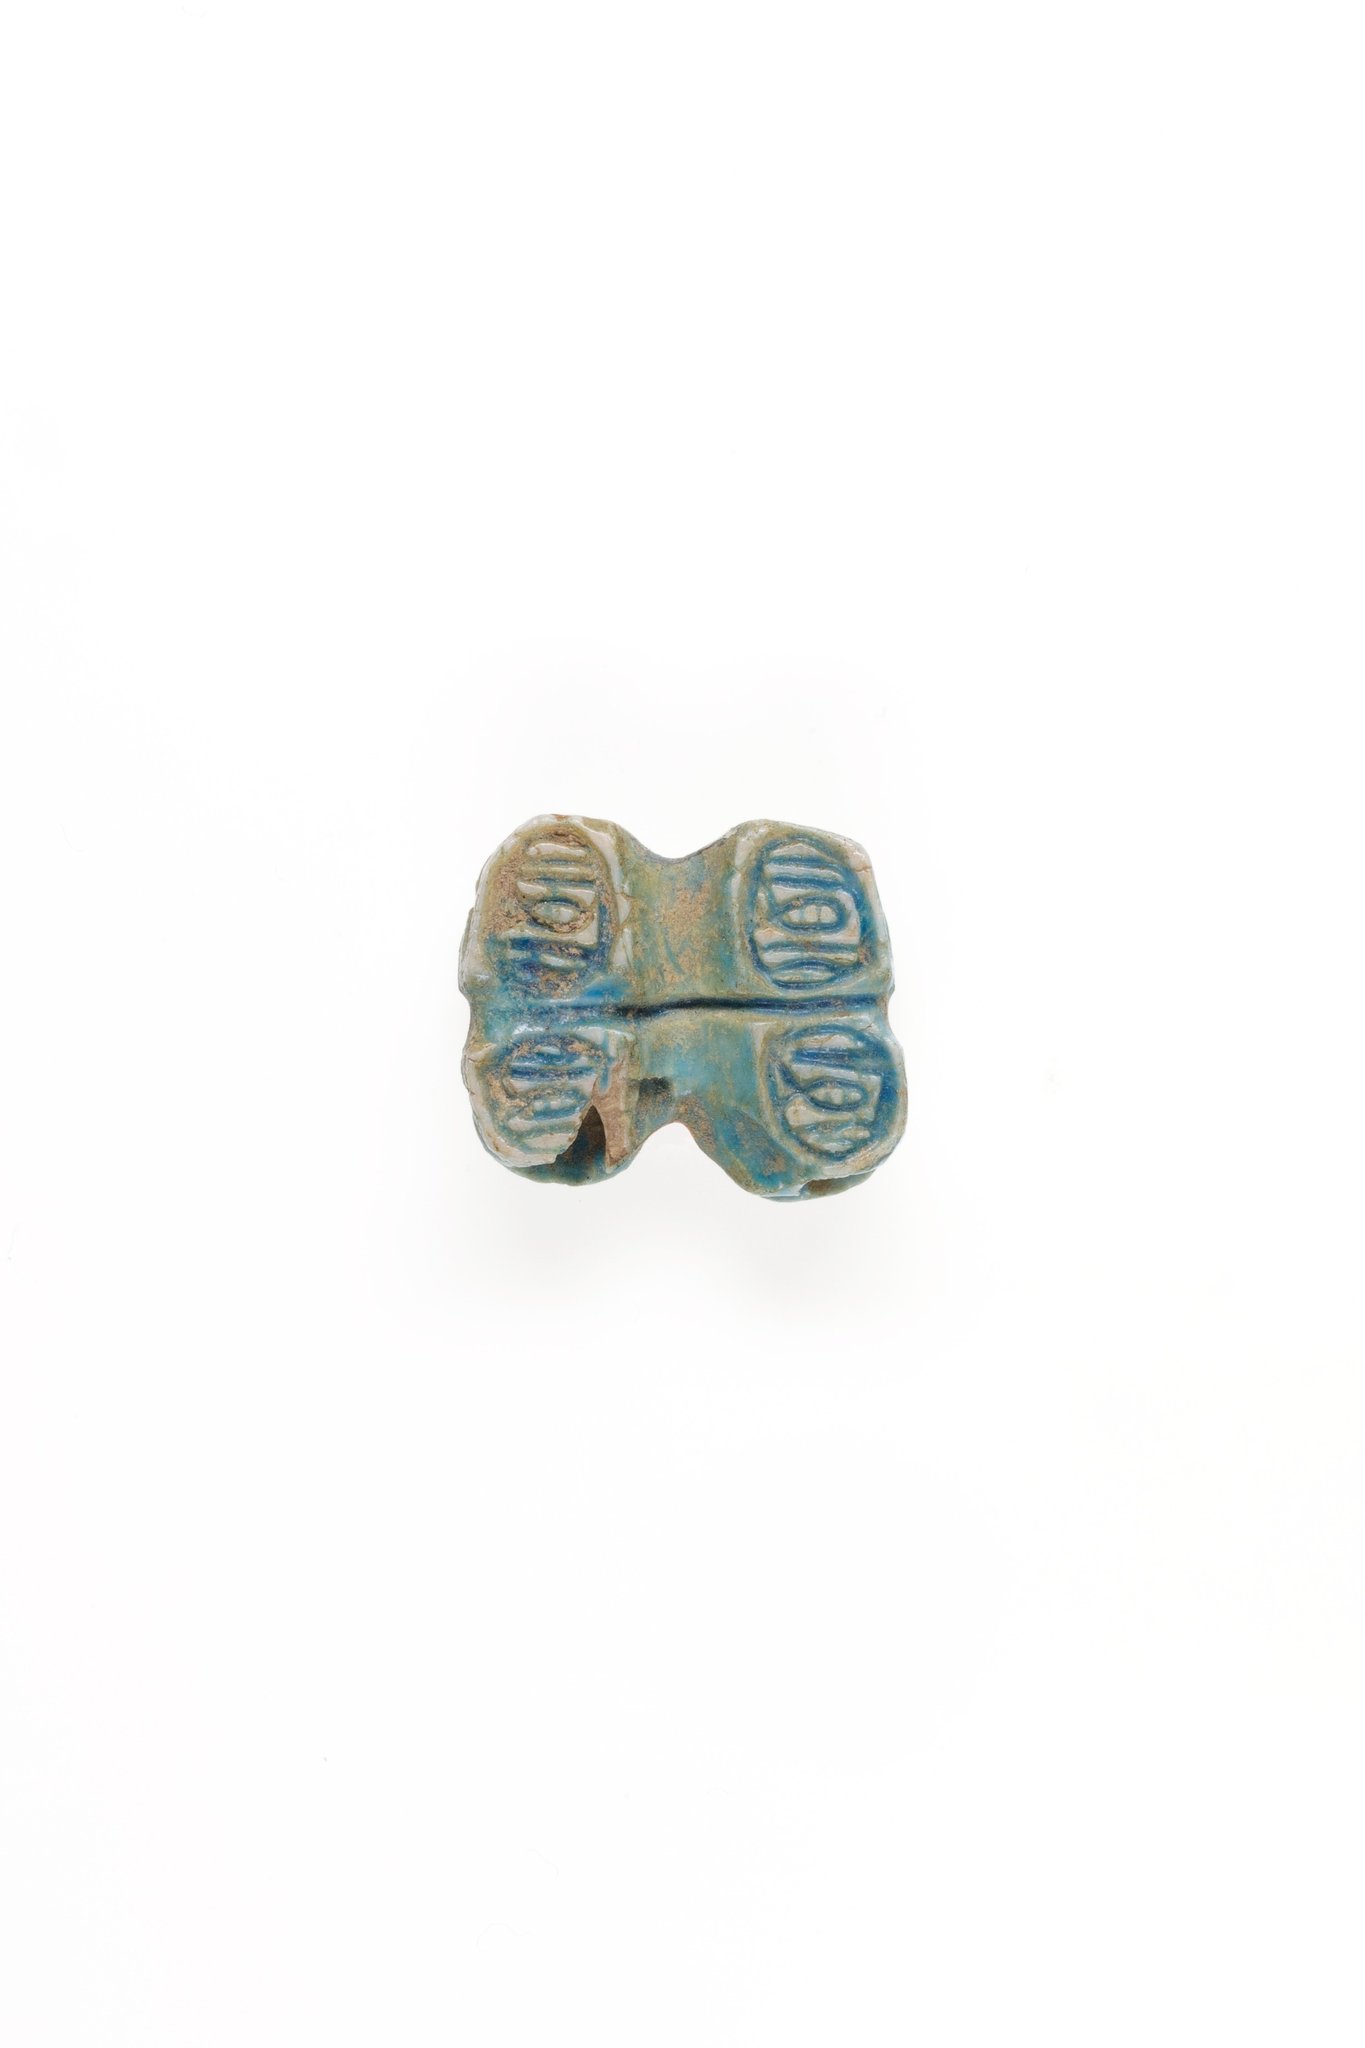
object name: scarab, imitation cartouche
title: Scarab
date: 1981-1295 BCE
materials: stone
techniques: glazing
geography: egypt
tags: scarabs